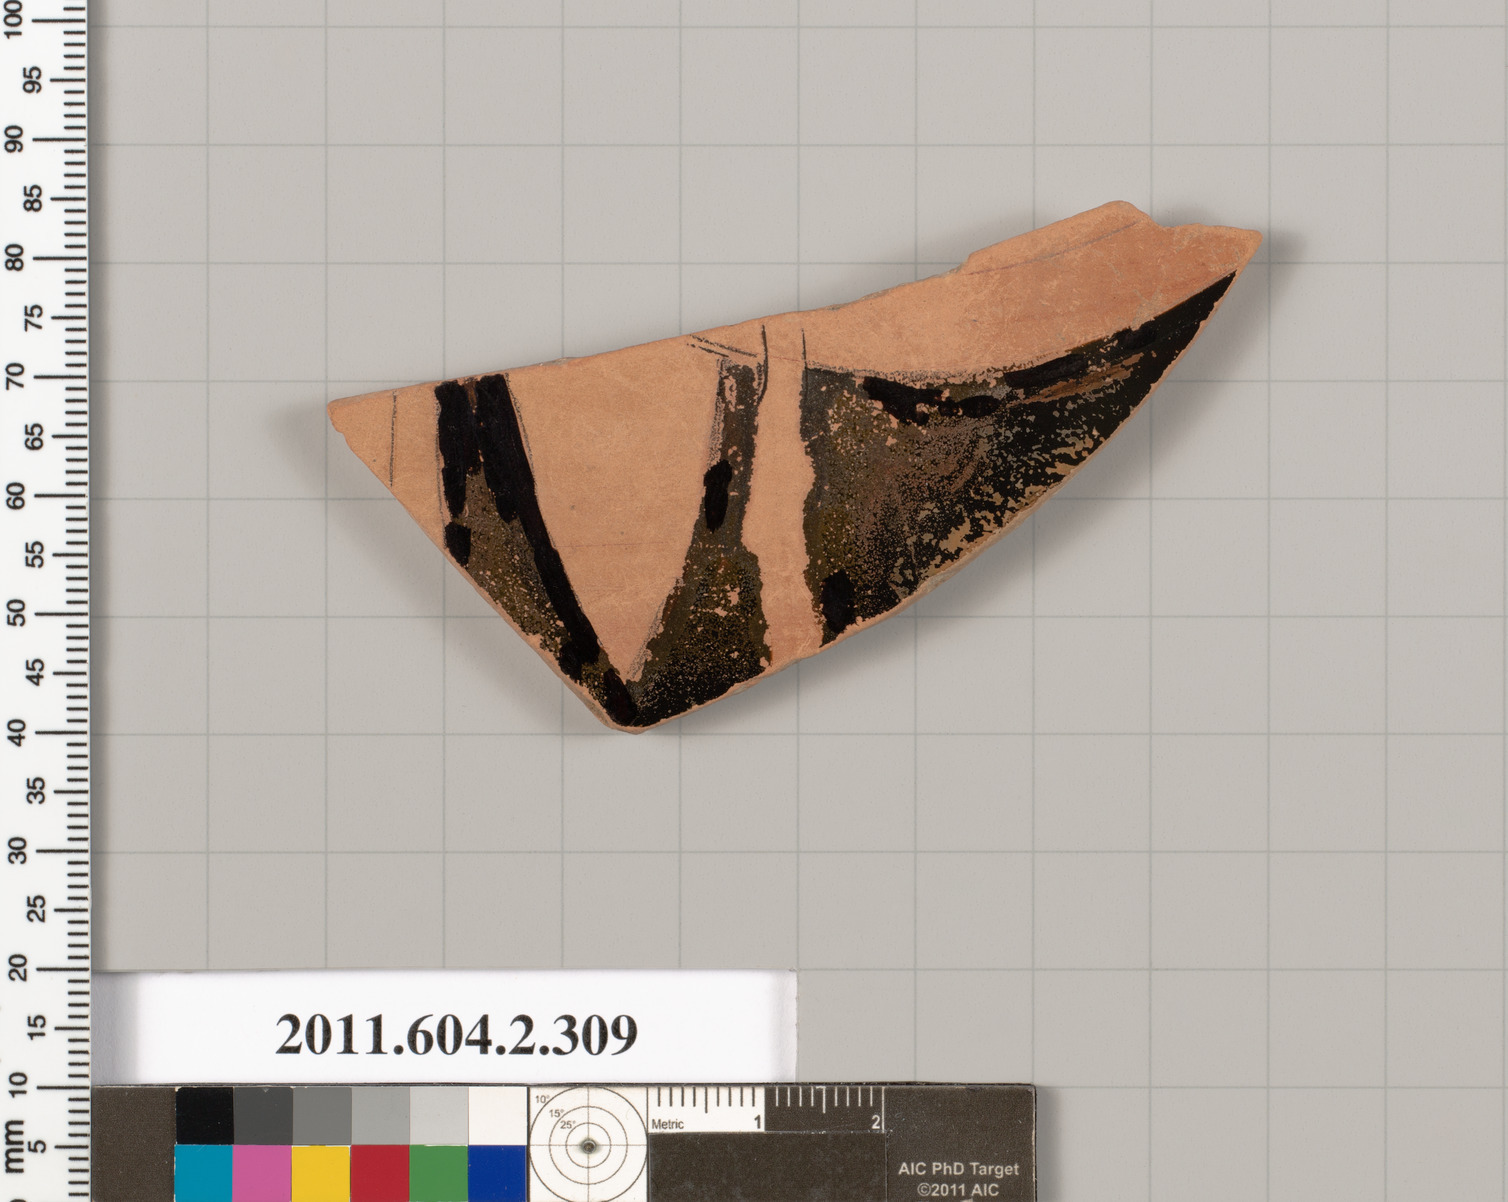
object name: column krater fragment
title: Terracotta fragment of a column-krater (bowl for mixing wine and water)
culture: greek, attic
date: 467-435 BCE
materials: terracotta